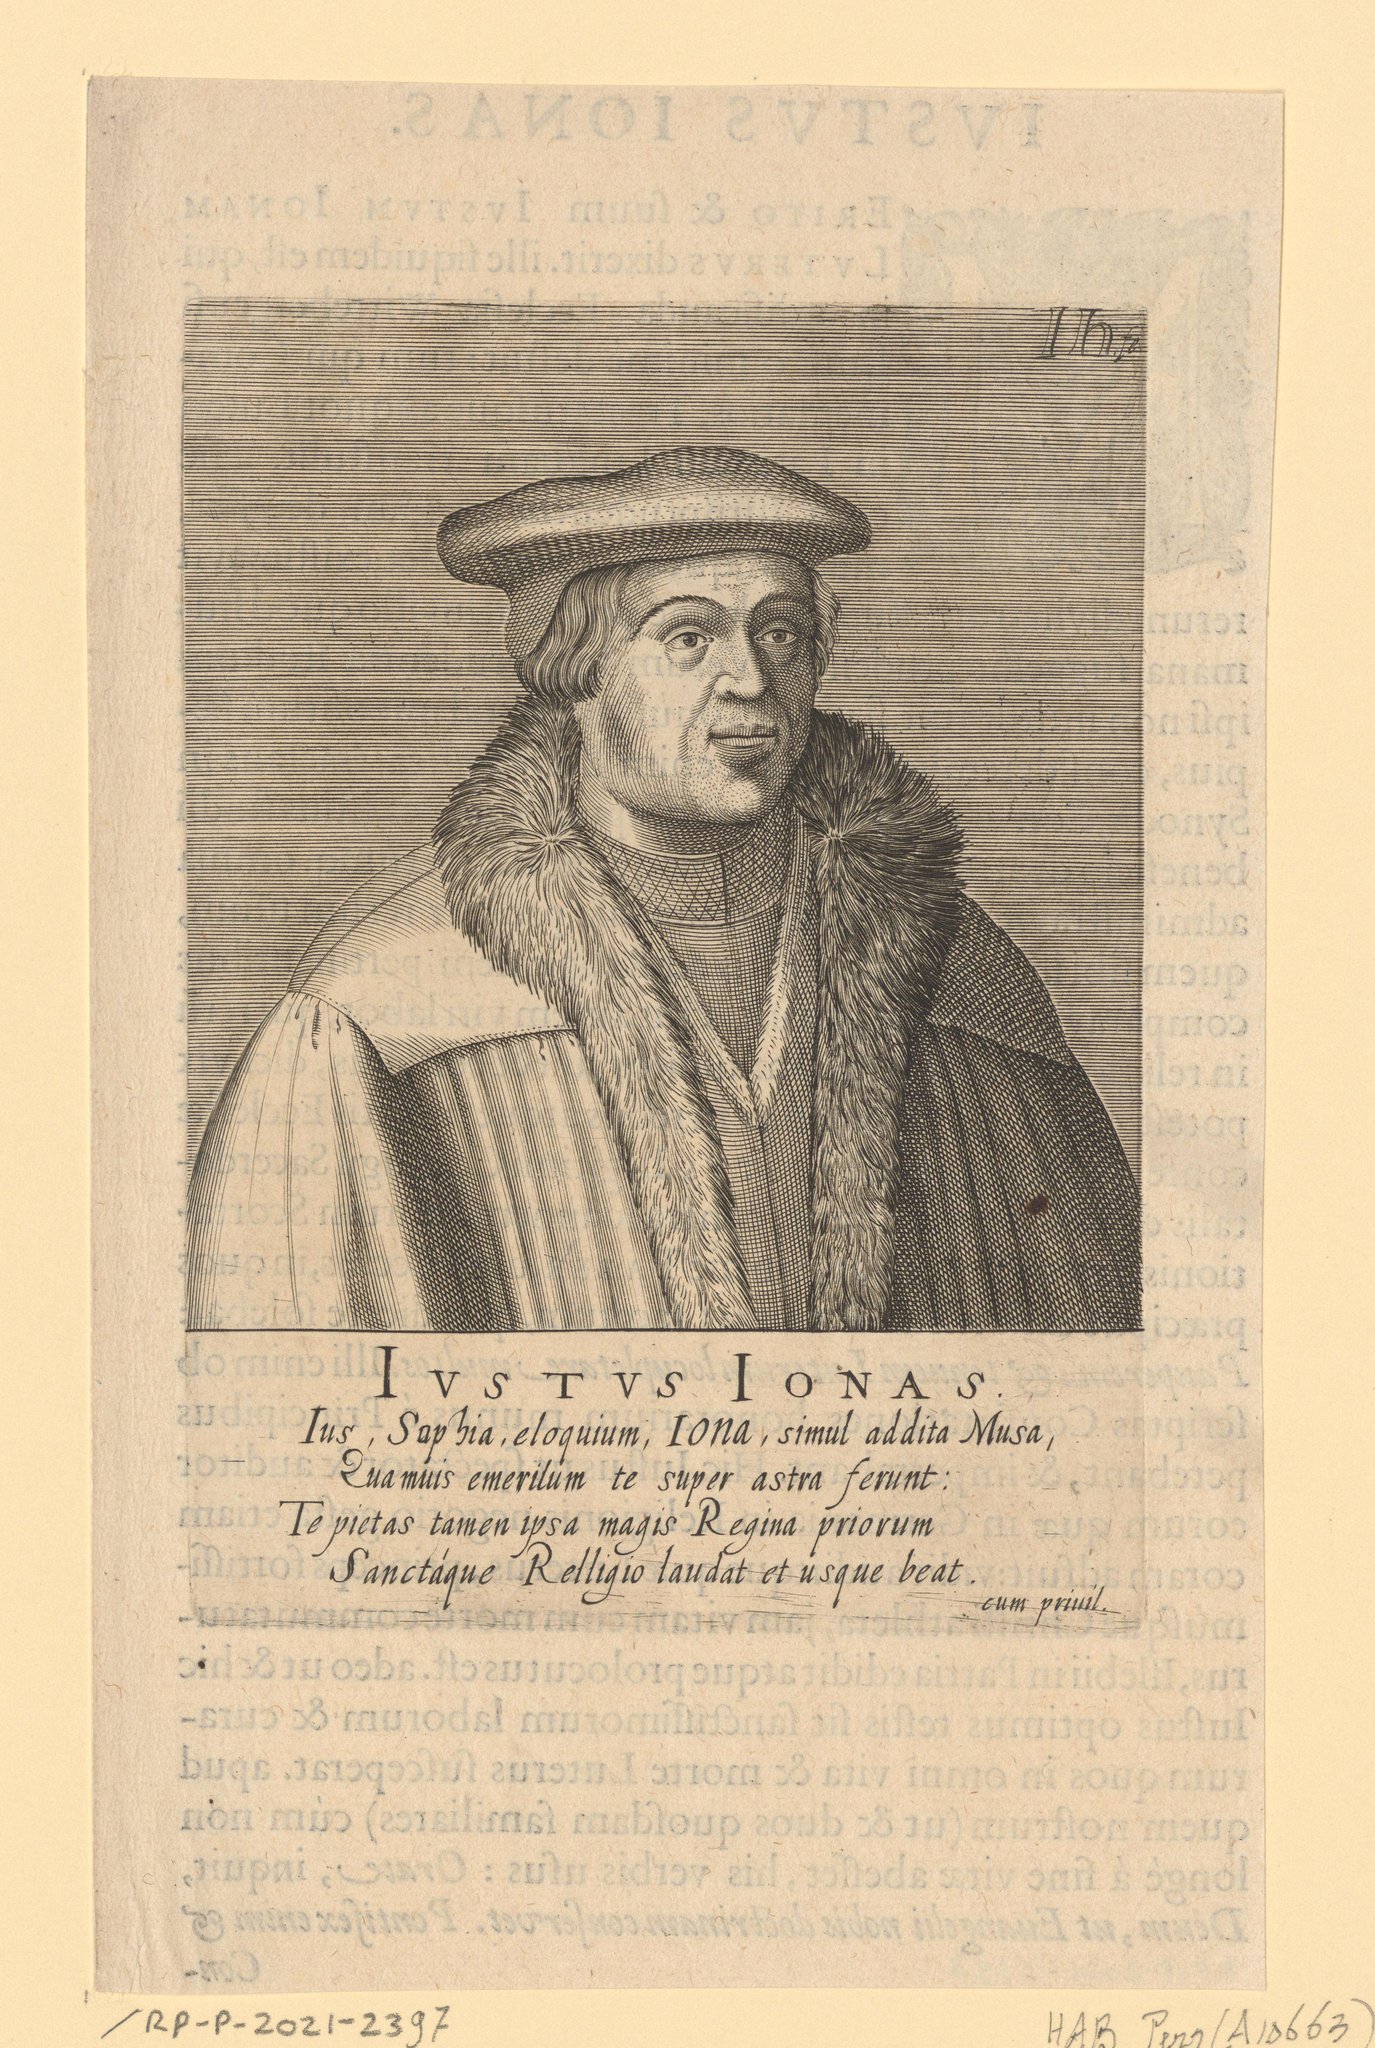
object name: print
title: Portret van Justus Jonas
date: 1602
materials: paper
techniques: engraving, letterpress printing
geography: the hague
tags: theologian, historical persons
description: Prent uit: Verheiden, Jacob. Præstantium aliquot theologorum, qui rom. antichristum præcipuè oppugnarunt, effigies. Den Haag: Hendrick Hondius I en Den Haag: Beukel Cornelisz. Nieulandt, 1602. Prent ook gebruikt in de serie 'Icones virorum nostra patrumq. memoria illustrium', uitgegeven door Hendrick Hondius I in 1599.